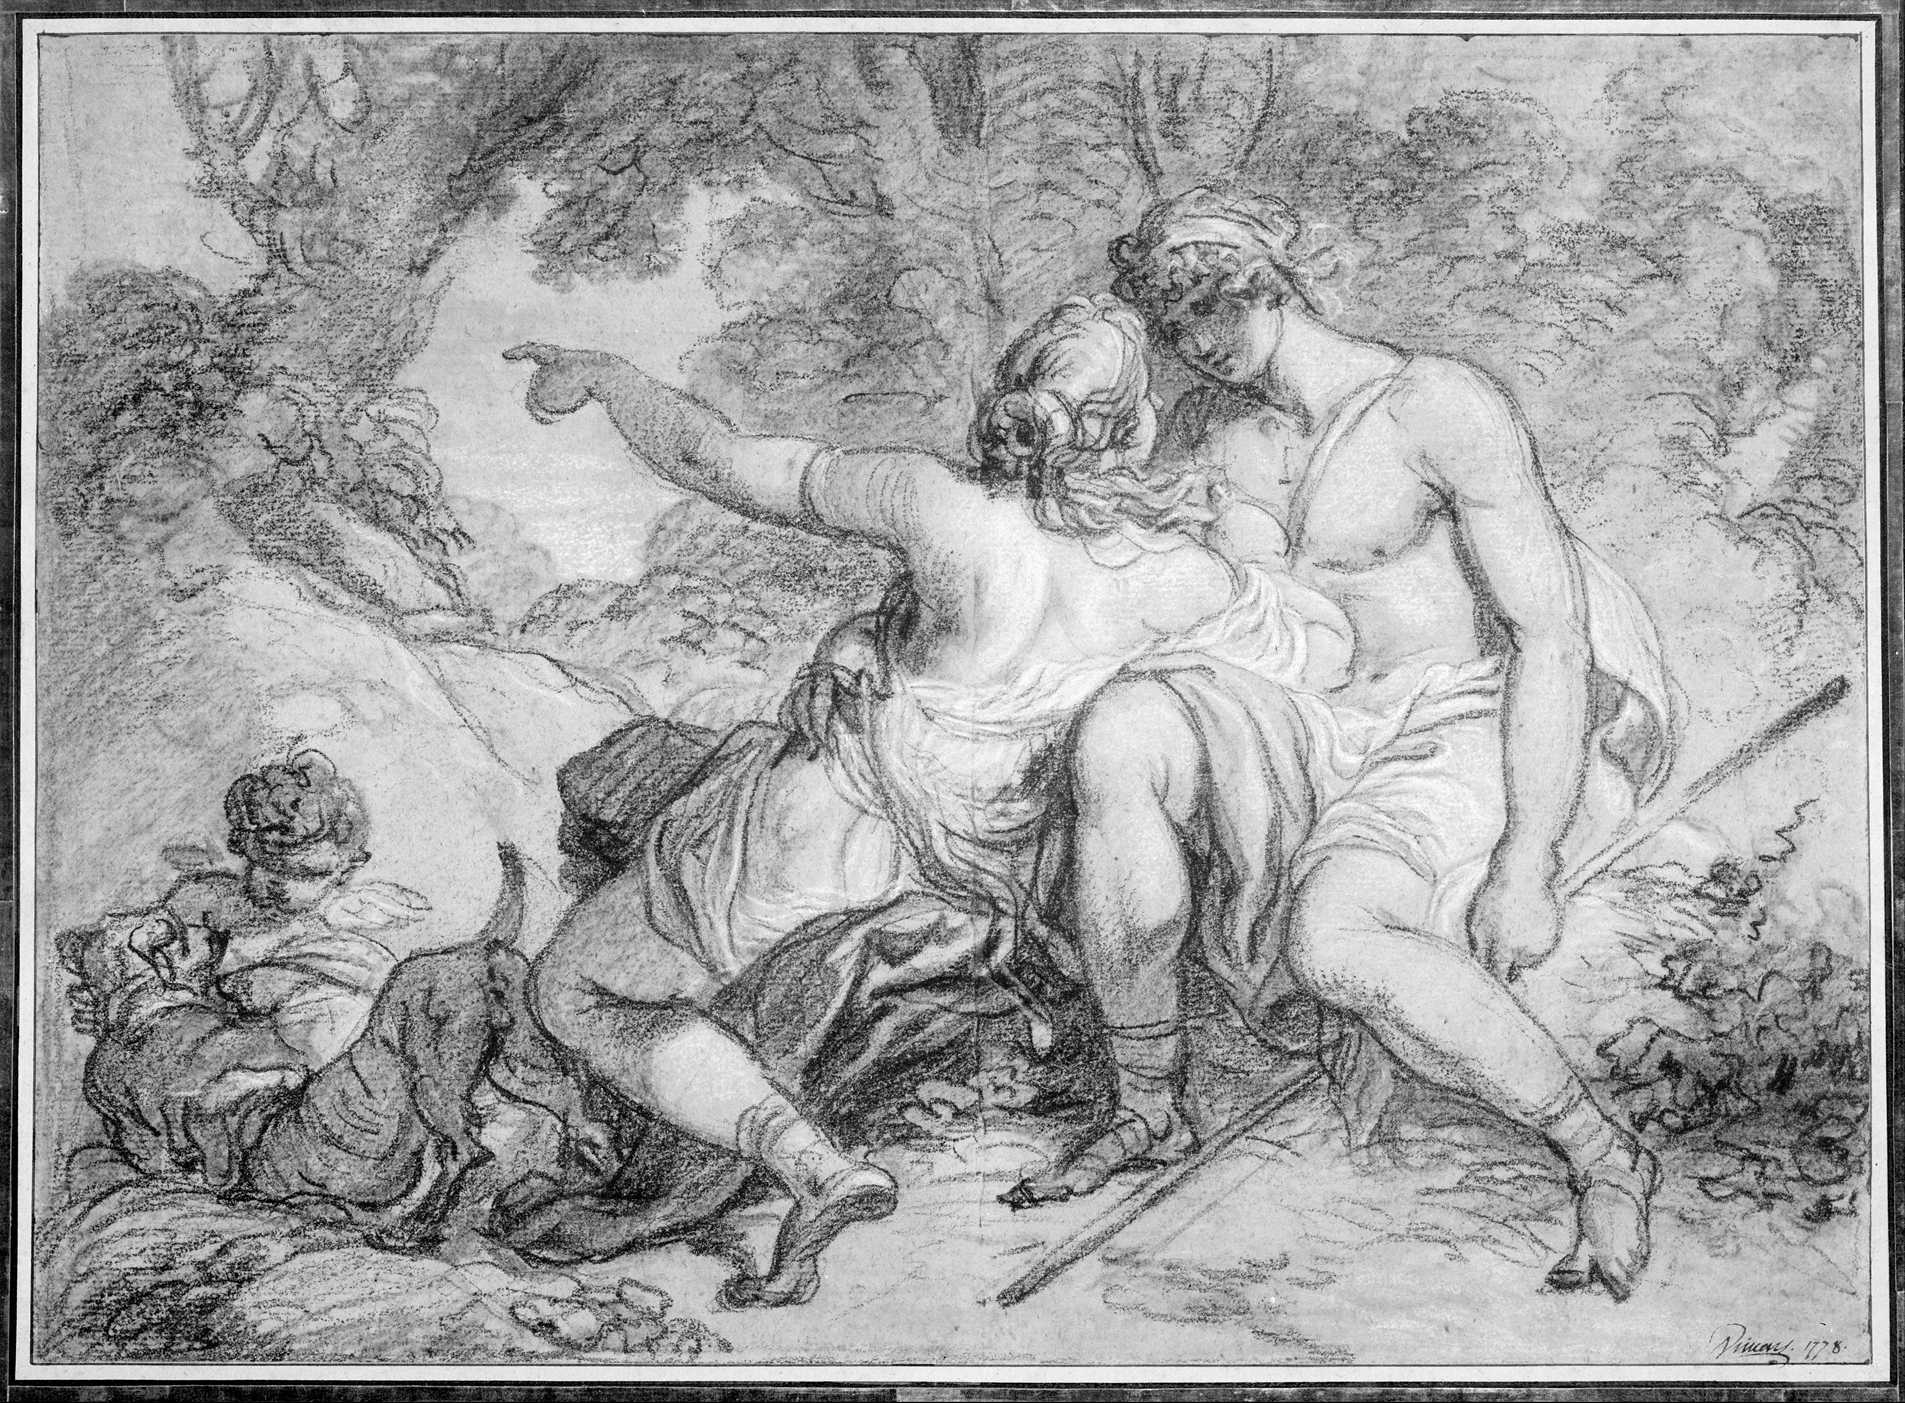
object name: drawing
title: Venus and Adonis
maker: françois andré vincent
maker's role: artist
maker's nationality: french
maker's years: 1746-1816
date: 1778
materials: chalk, charcoal, paper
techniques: heightening, stumping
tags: adonis,venus,dogs